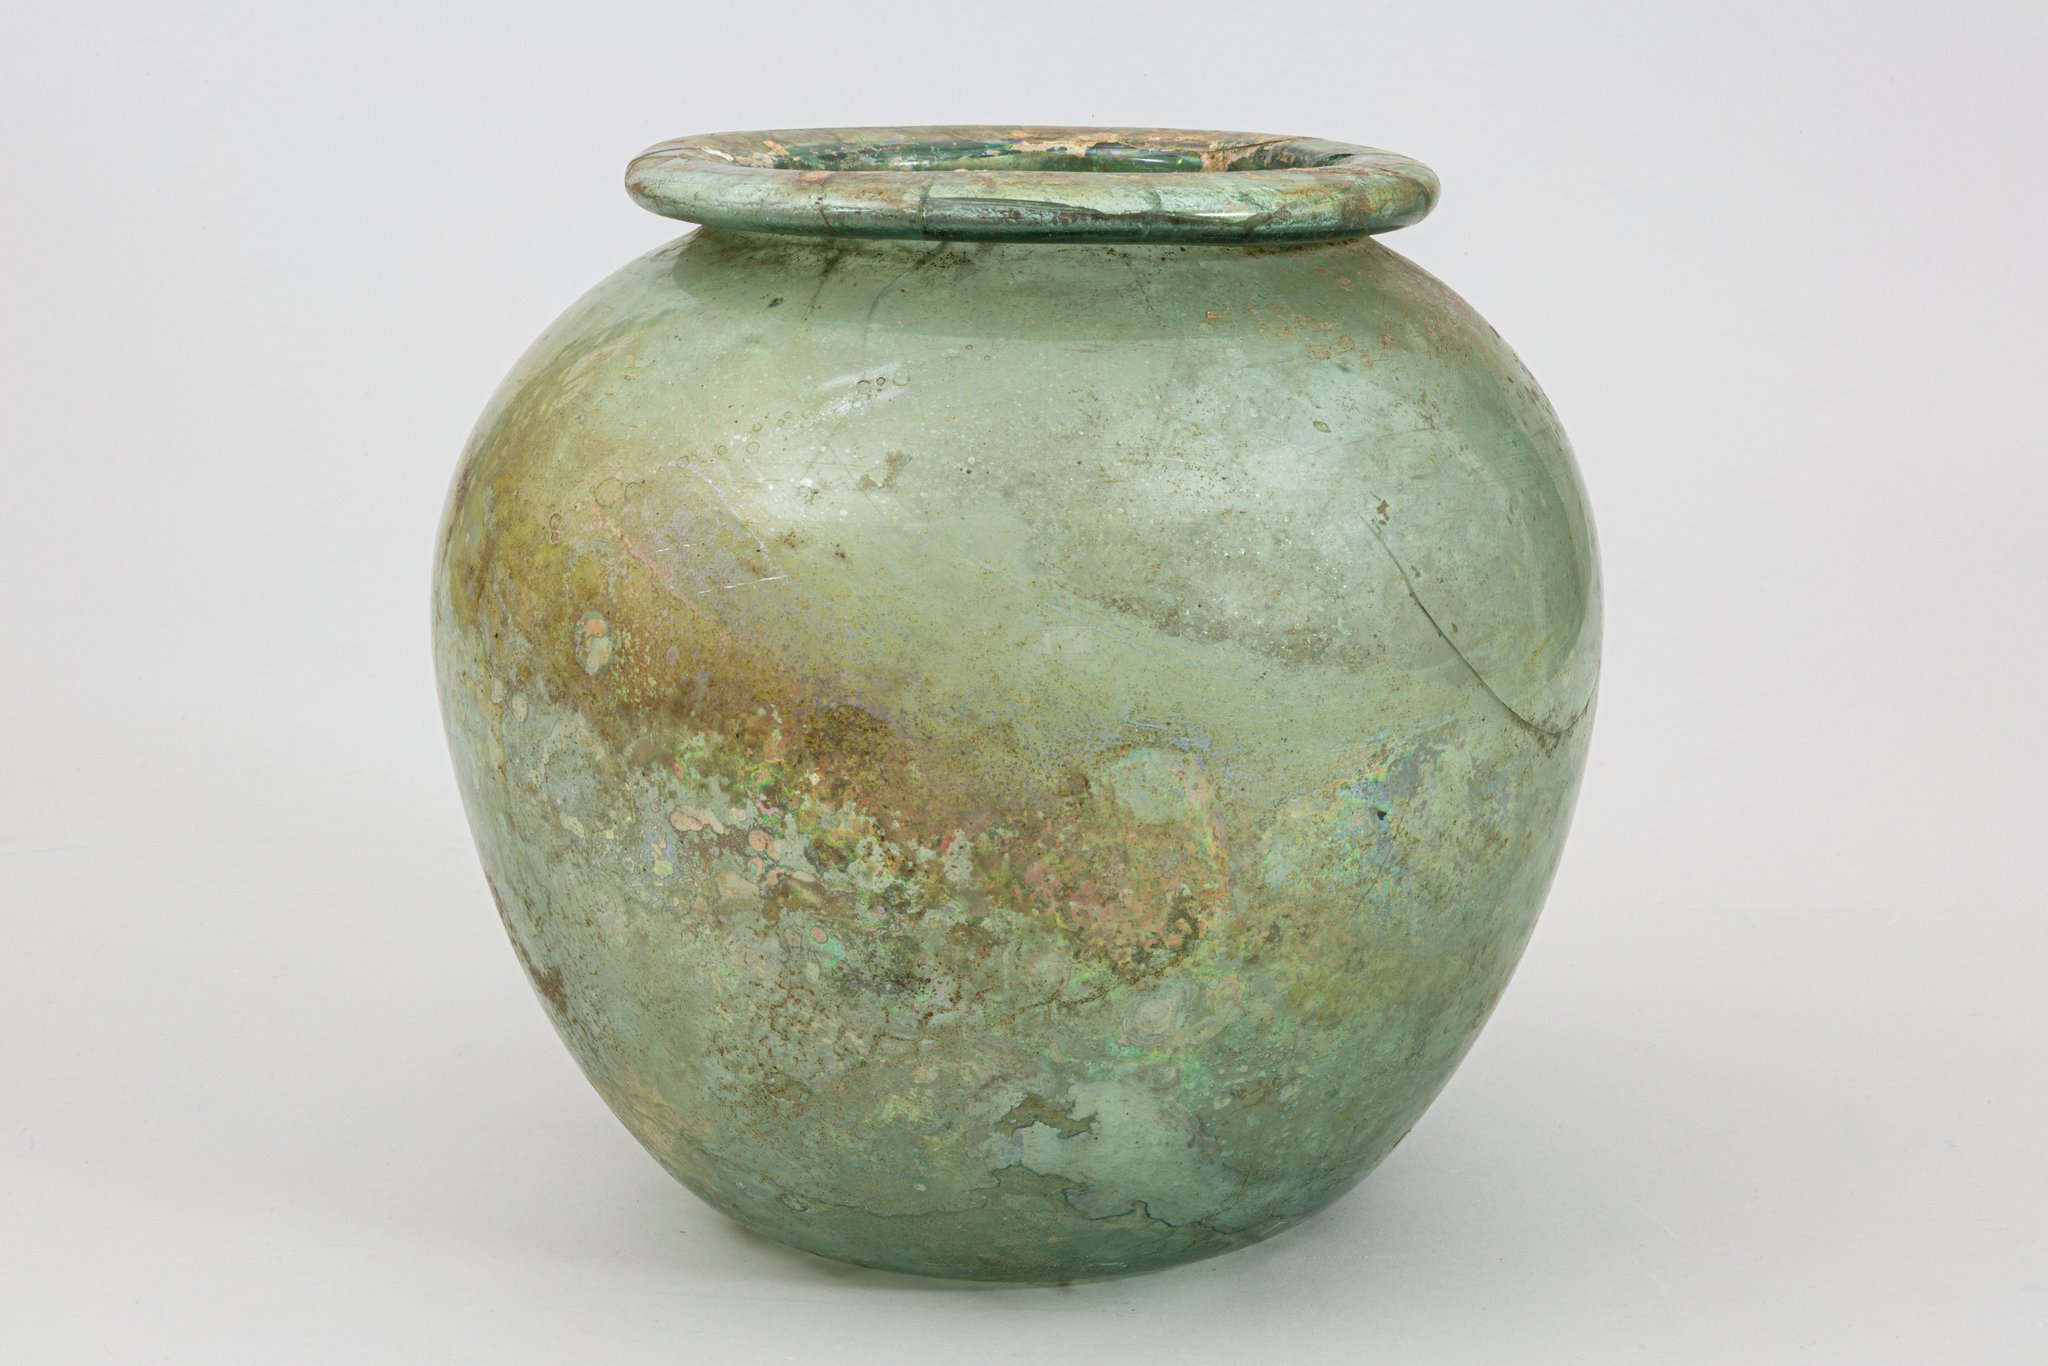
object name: jar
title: Glass cinerary urn (olla)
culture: roman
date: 34-200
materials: glass